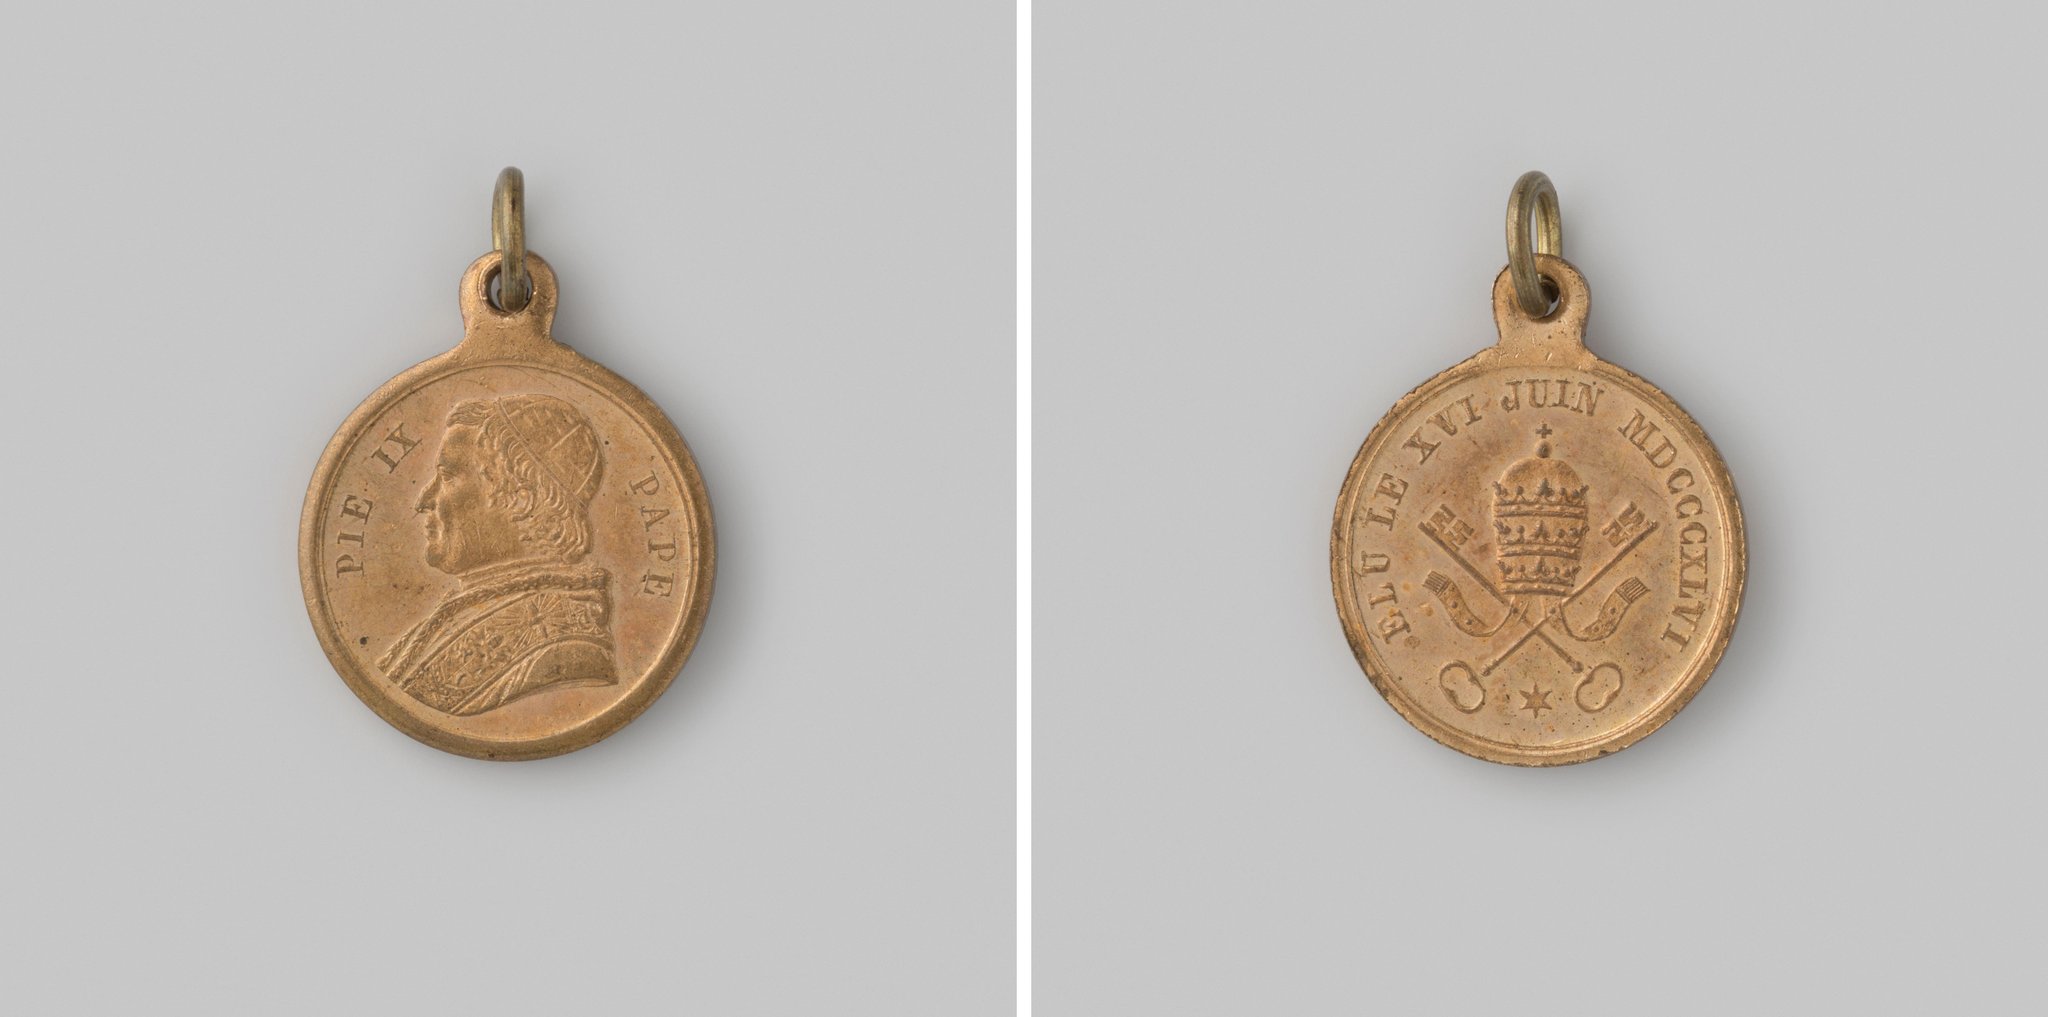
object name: history medal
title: Verkiezing van Paus Pius IX 1846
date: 1846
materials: brass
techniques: striking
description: Klein messing draagpenninkje met oog en draagring, op de voorzijde het borstbeeld van Paus Pius IX naar links met omschrift, op de keerzijde het pauselijk wapen met omschrift.